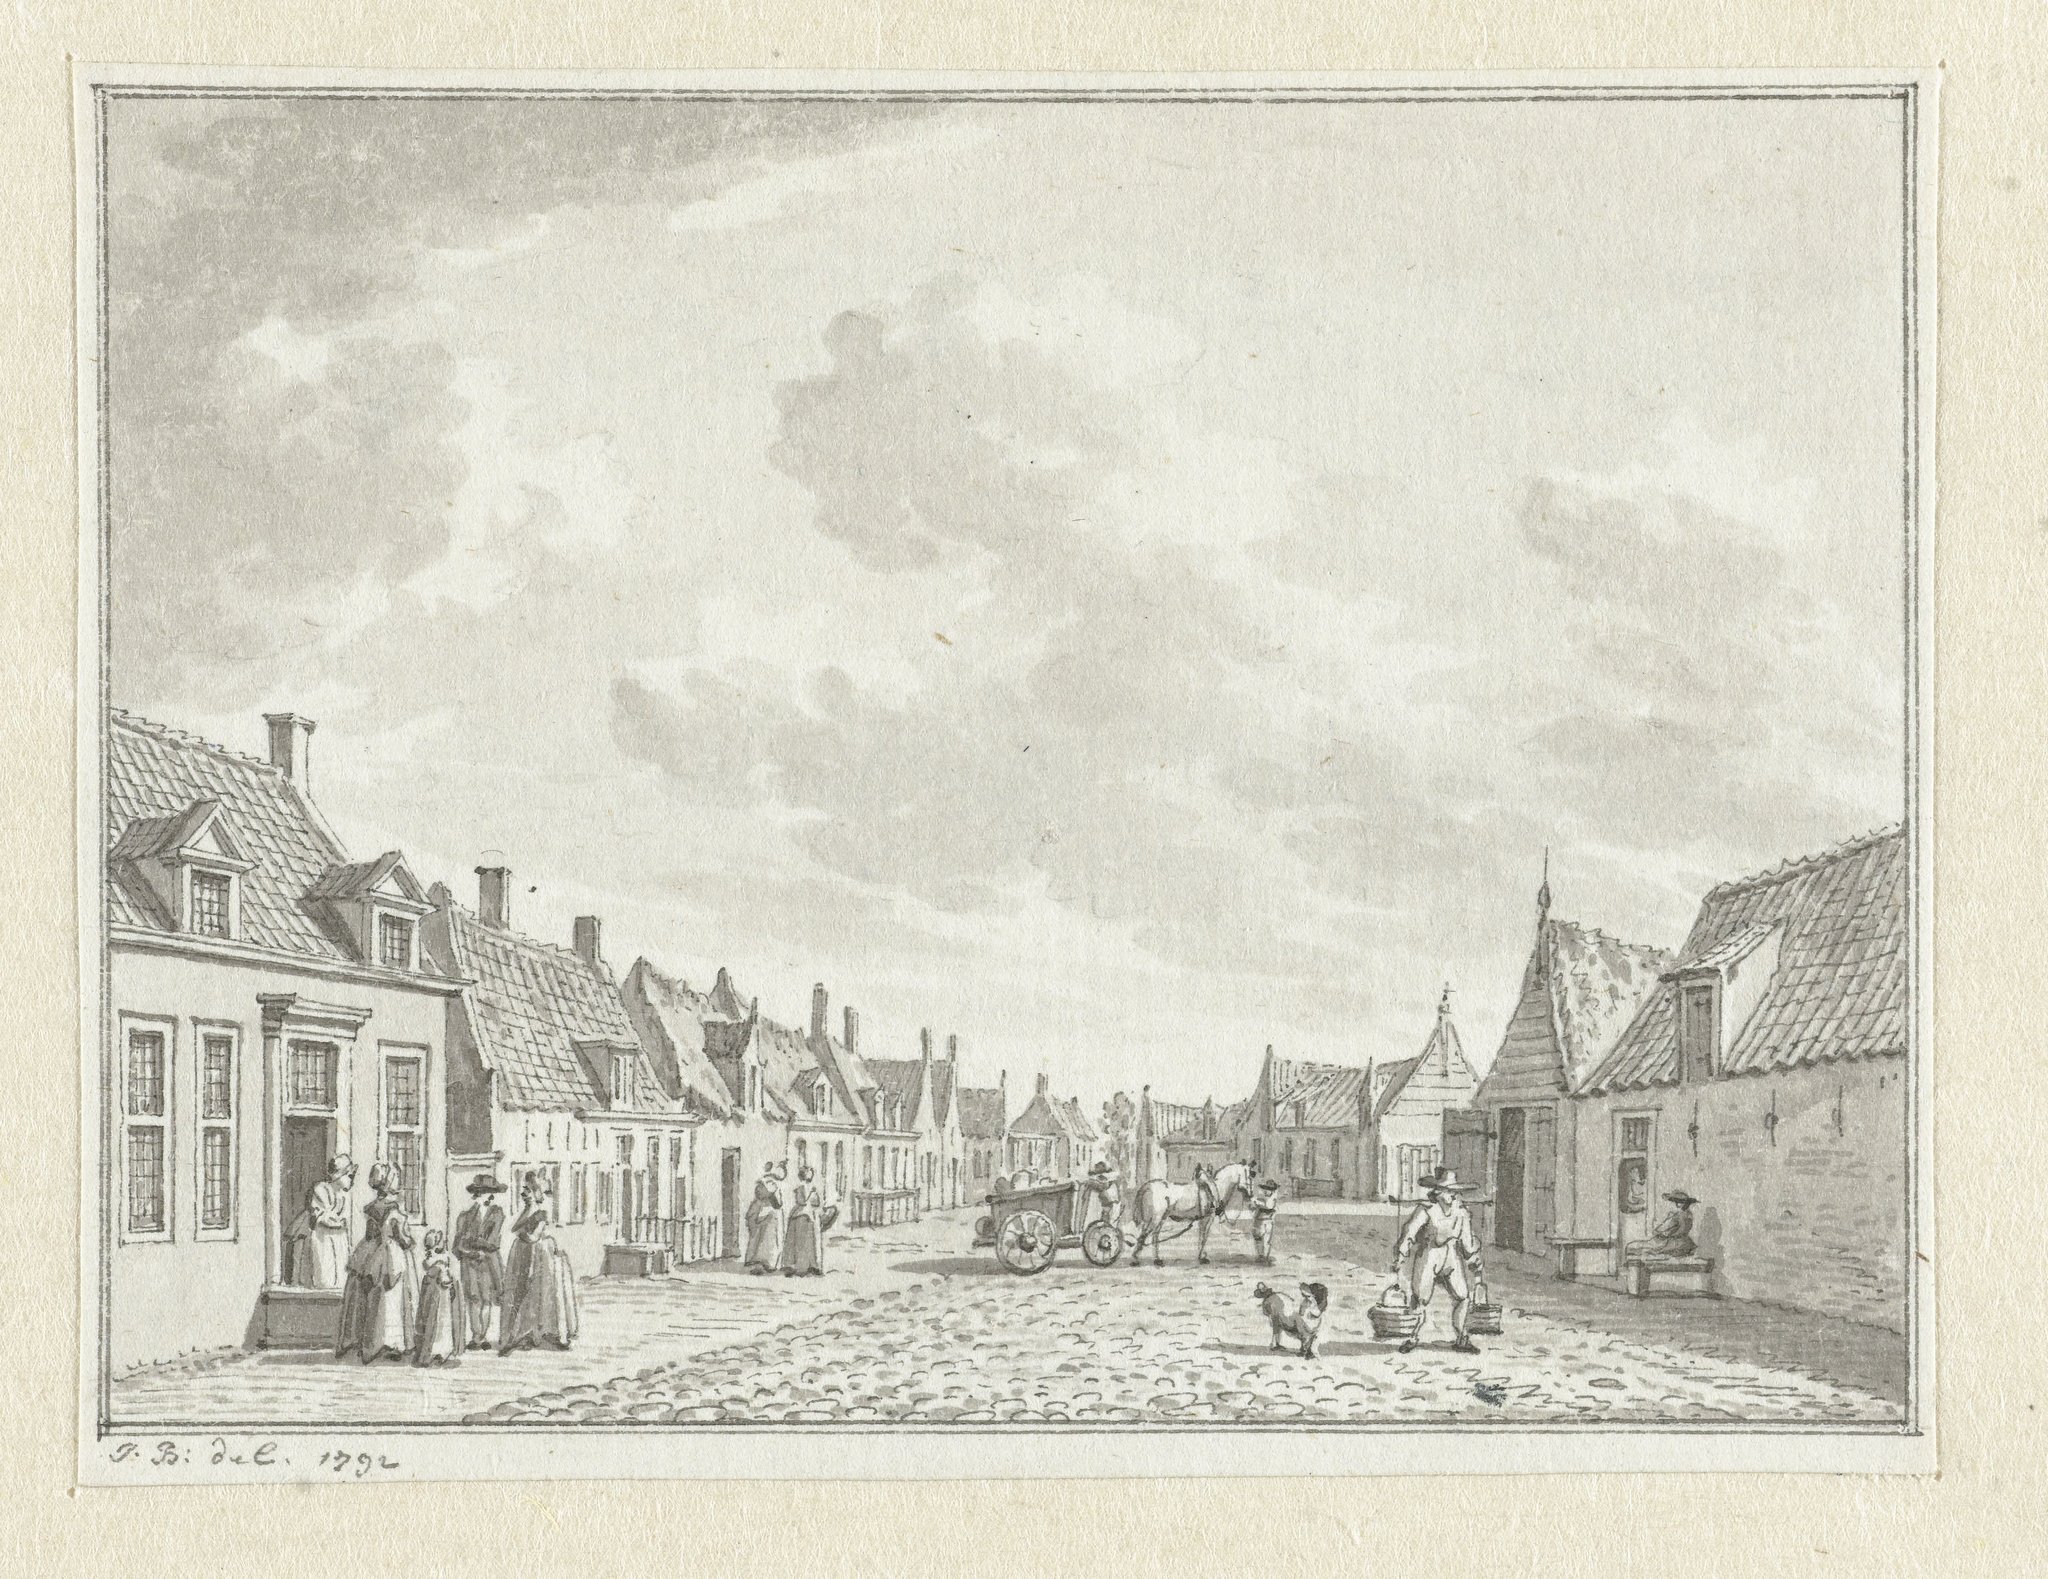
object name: drawing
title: Gezicht te Zoutelande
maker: jan bulthuis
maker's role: draughtsman, print maker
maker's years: 1750-1801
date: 1792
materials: ink, paper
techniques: brush, pen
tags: village, street